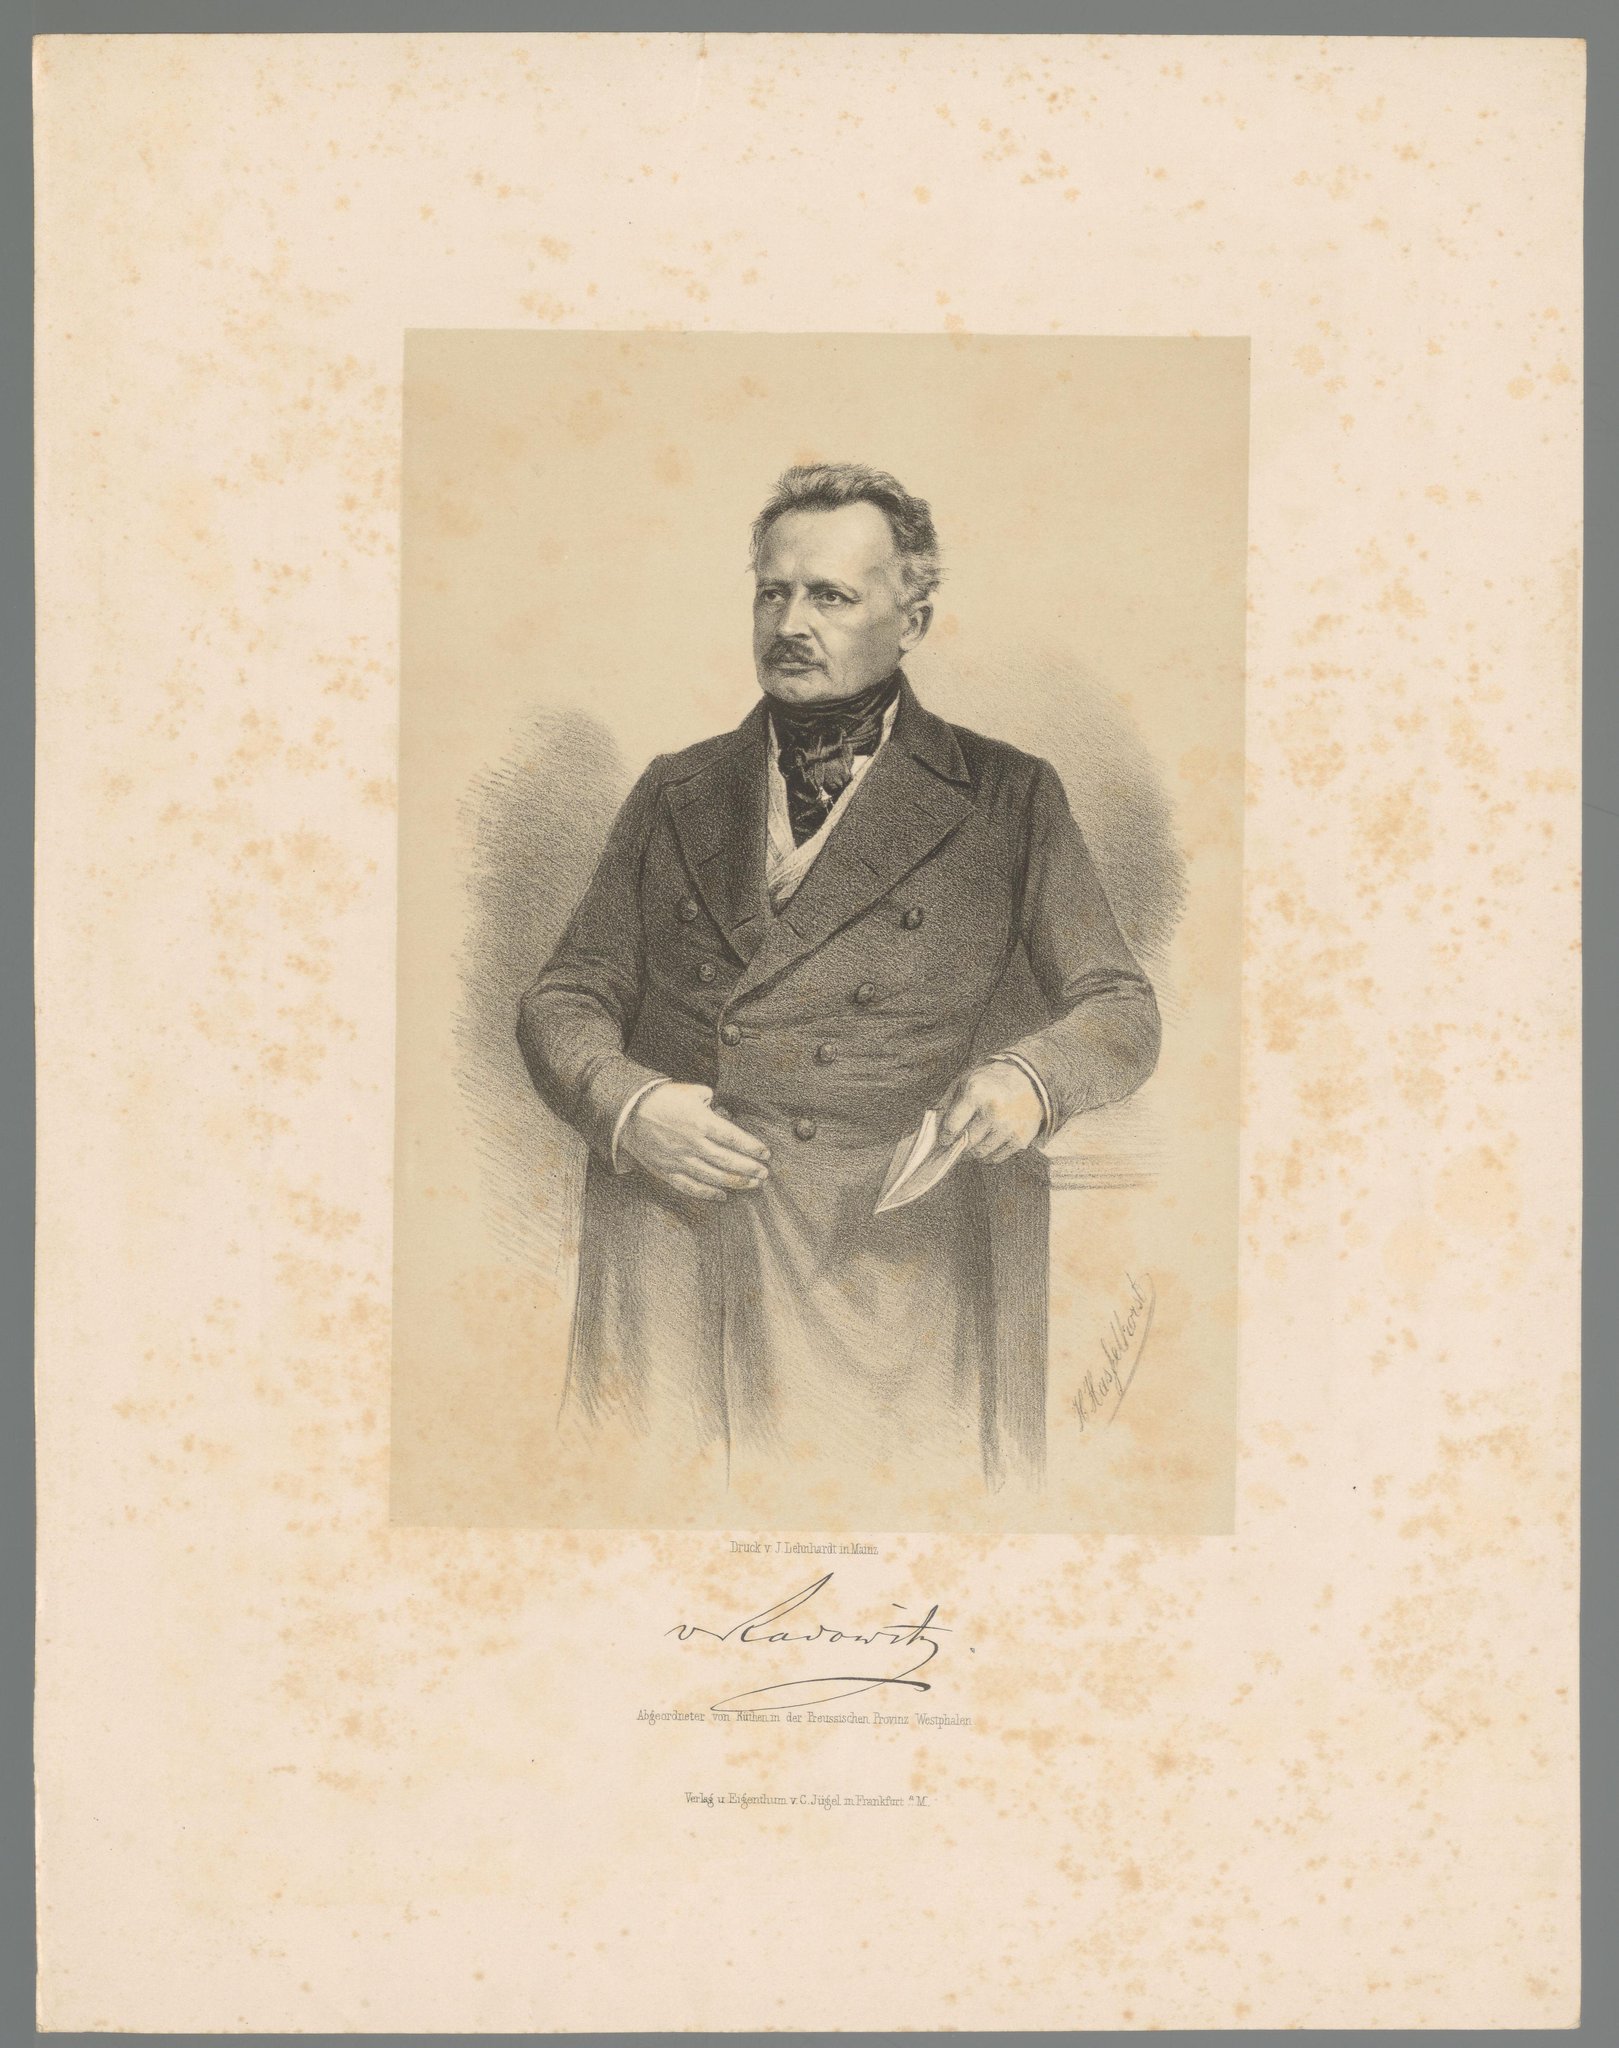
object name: print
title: Portret van Joseph Maria von Radowitz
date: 1835-1862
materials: paper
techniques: lithograph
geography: mainz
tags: berlin, politician, official; civil servant; functionary (in general), historical persons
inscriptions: collector's mark: Lugt 2228